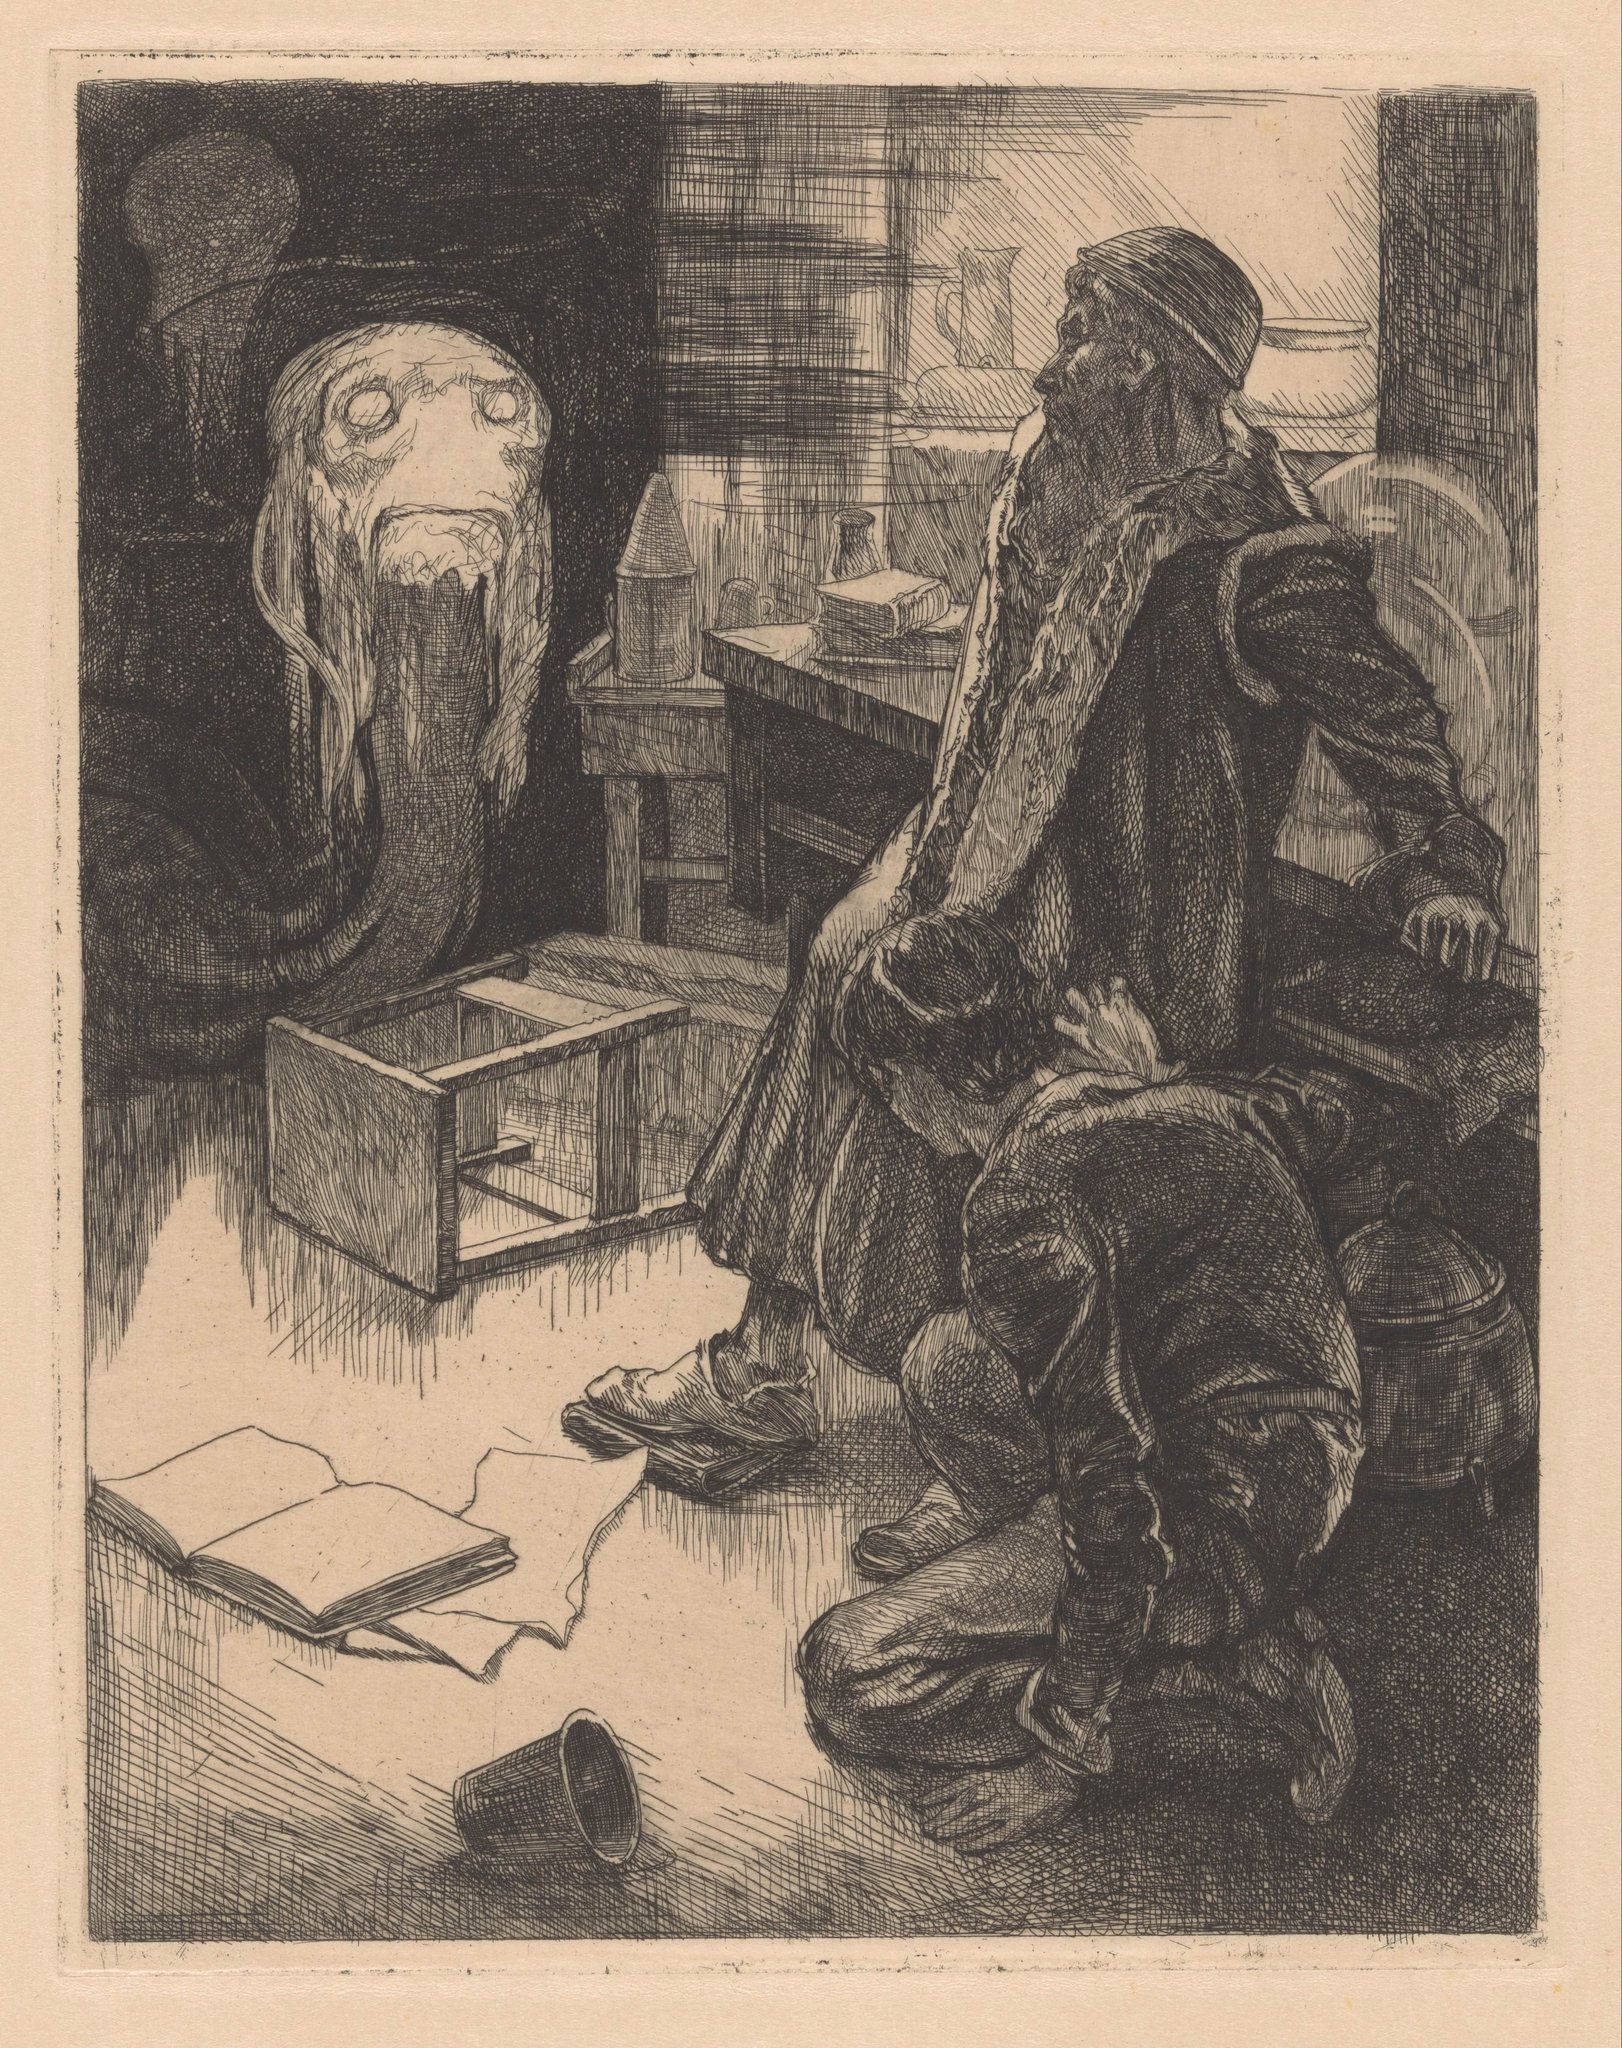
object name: print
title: Twee mannen en een monster in een werkkamer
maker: johannes josephus aarts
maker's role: draughtsman, print maker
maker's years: 1871-1934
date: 1881-1934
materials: paper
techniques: etching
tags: surrealia, surrealistic representations, mis-shapen animals; monsters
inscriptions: collector's mark: Lugt 2760, collector's mark: Lugt 2228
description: Een bebaarde man in een mantel leunt achterover tegen een werktafel. Rechts van hem knielt een andere man. Ze kijken beiden naar links, waar zich een monster met holle ogen en het lichaam van een slang ophoudt. Op de grond liggen een omgevallen kruk en een opengeslagen boek.